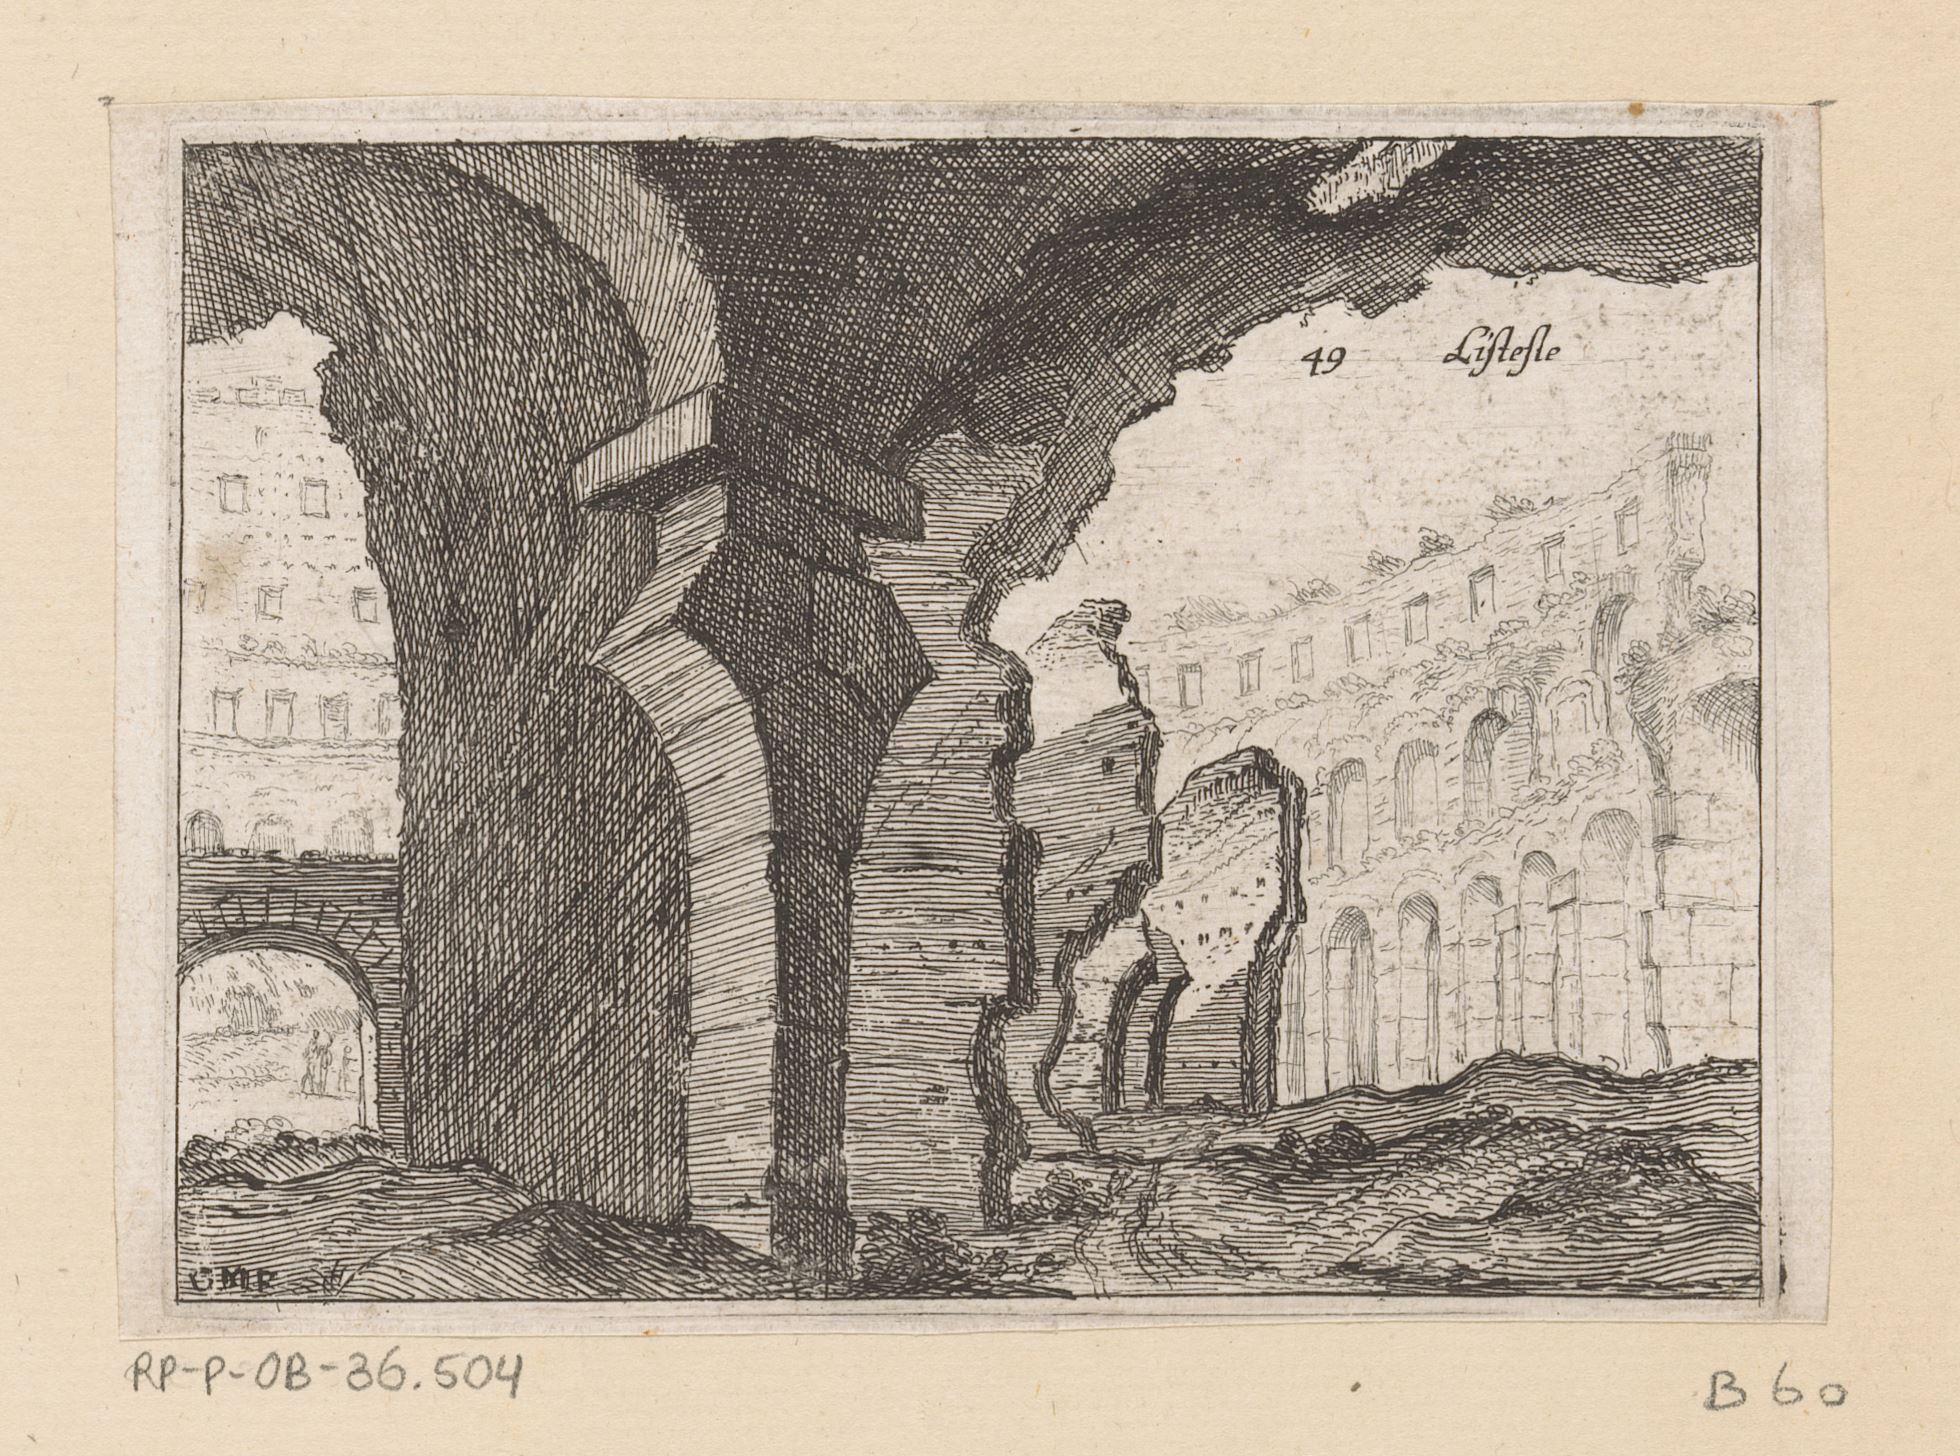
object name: print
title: Alcune vedute et prospettive di luoghi dishabitati di Roma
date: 1629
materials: paper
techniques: etching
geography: italy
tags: landscape with ruins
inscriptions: collector's mark: Lugt 2228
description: Deze prent maakt deel uit van een reeks van 52 prenten.